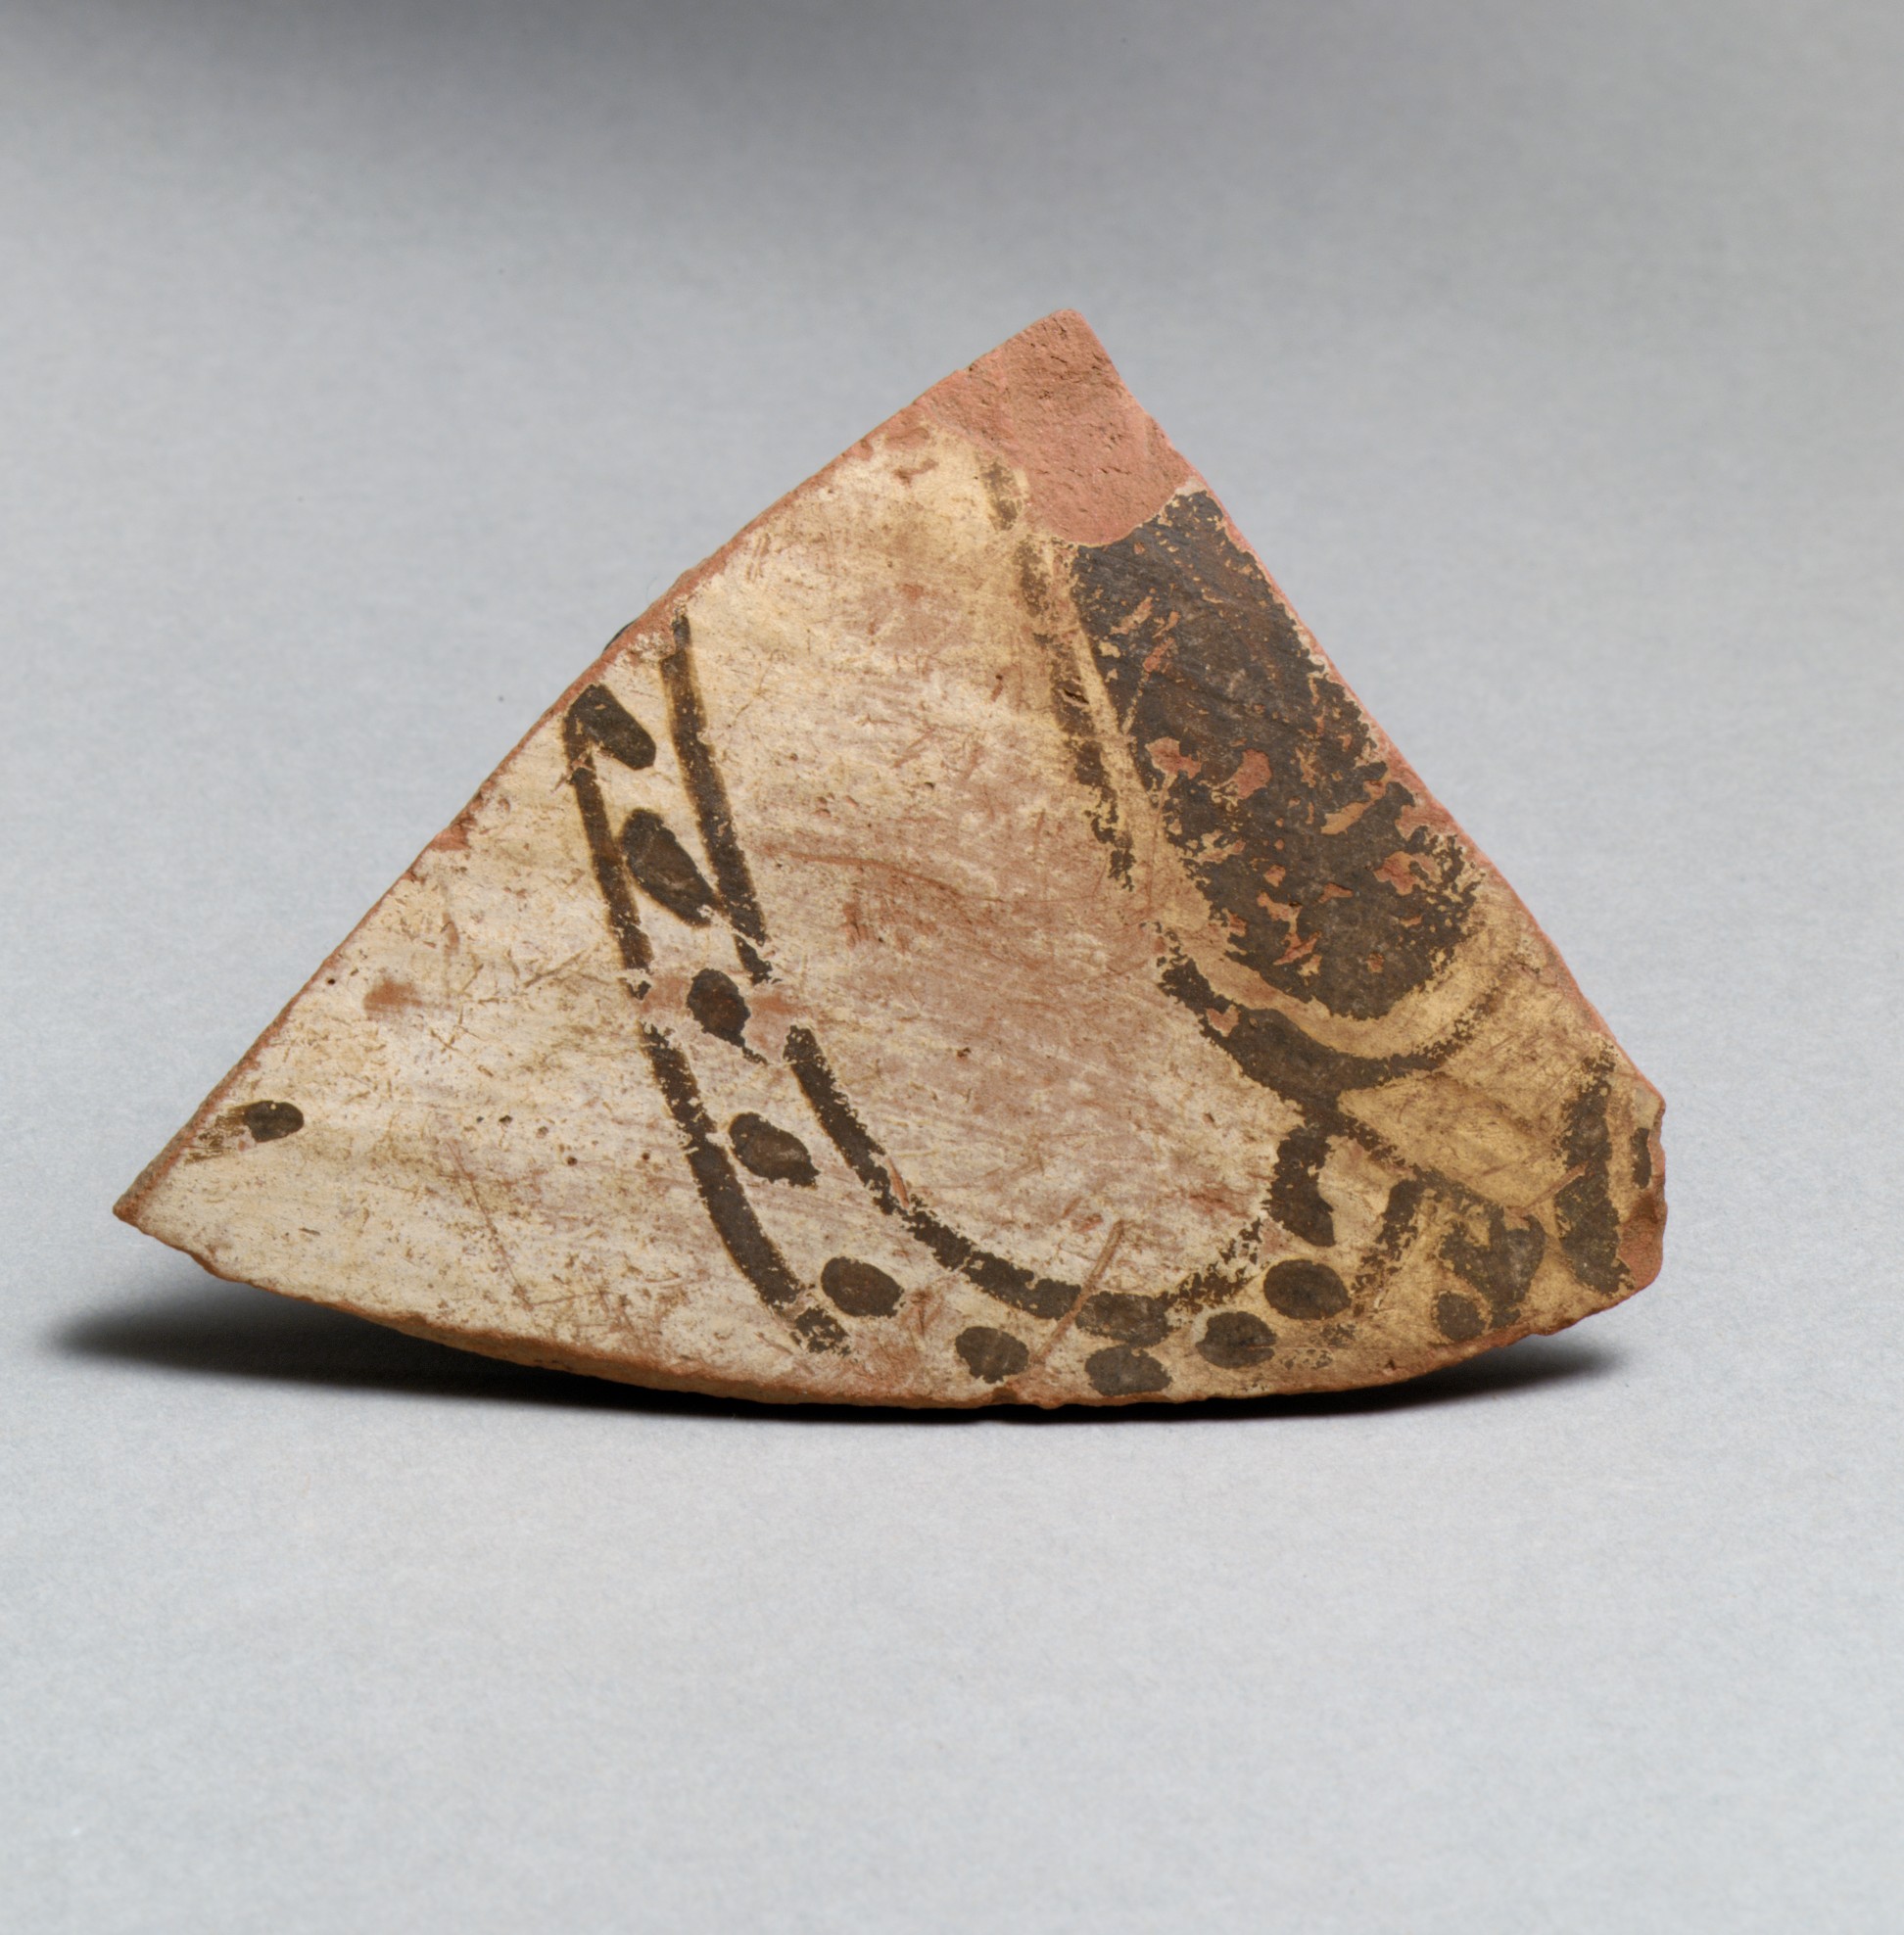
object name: vase fragment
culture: greek or lydian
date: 900-30 BCE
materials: terracotta